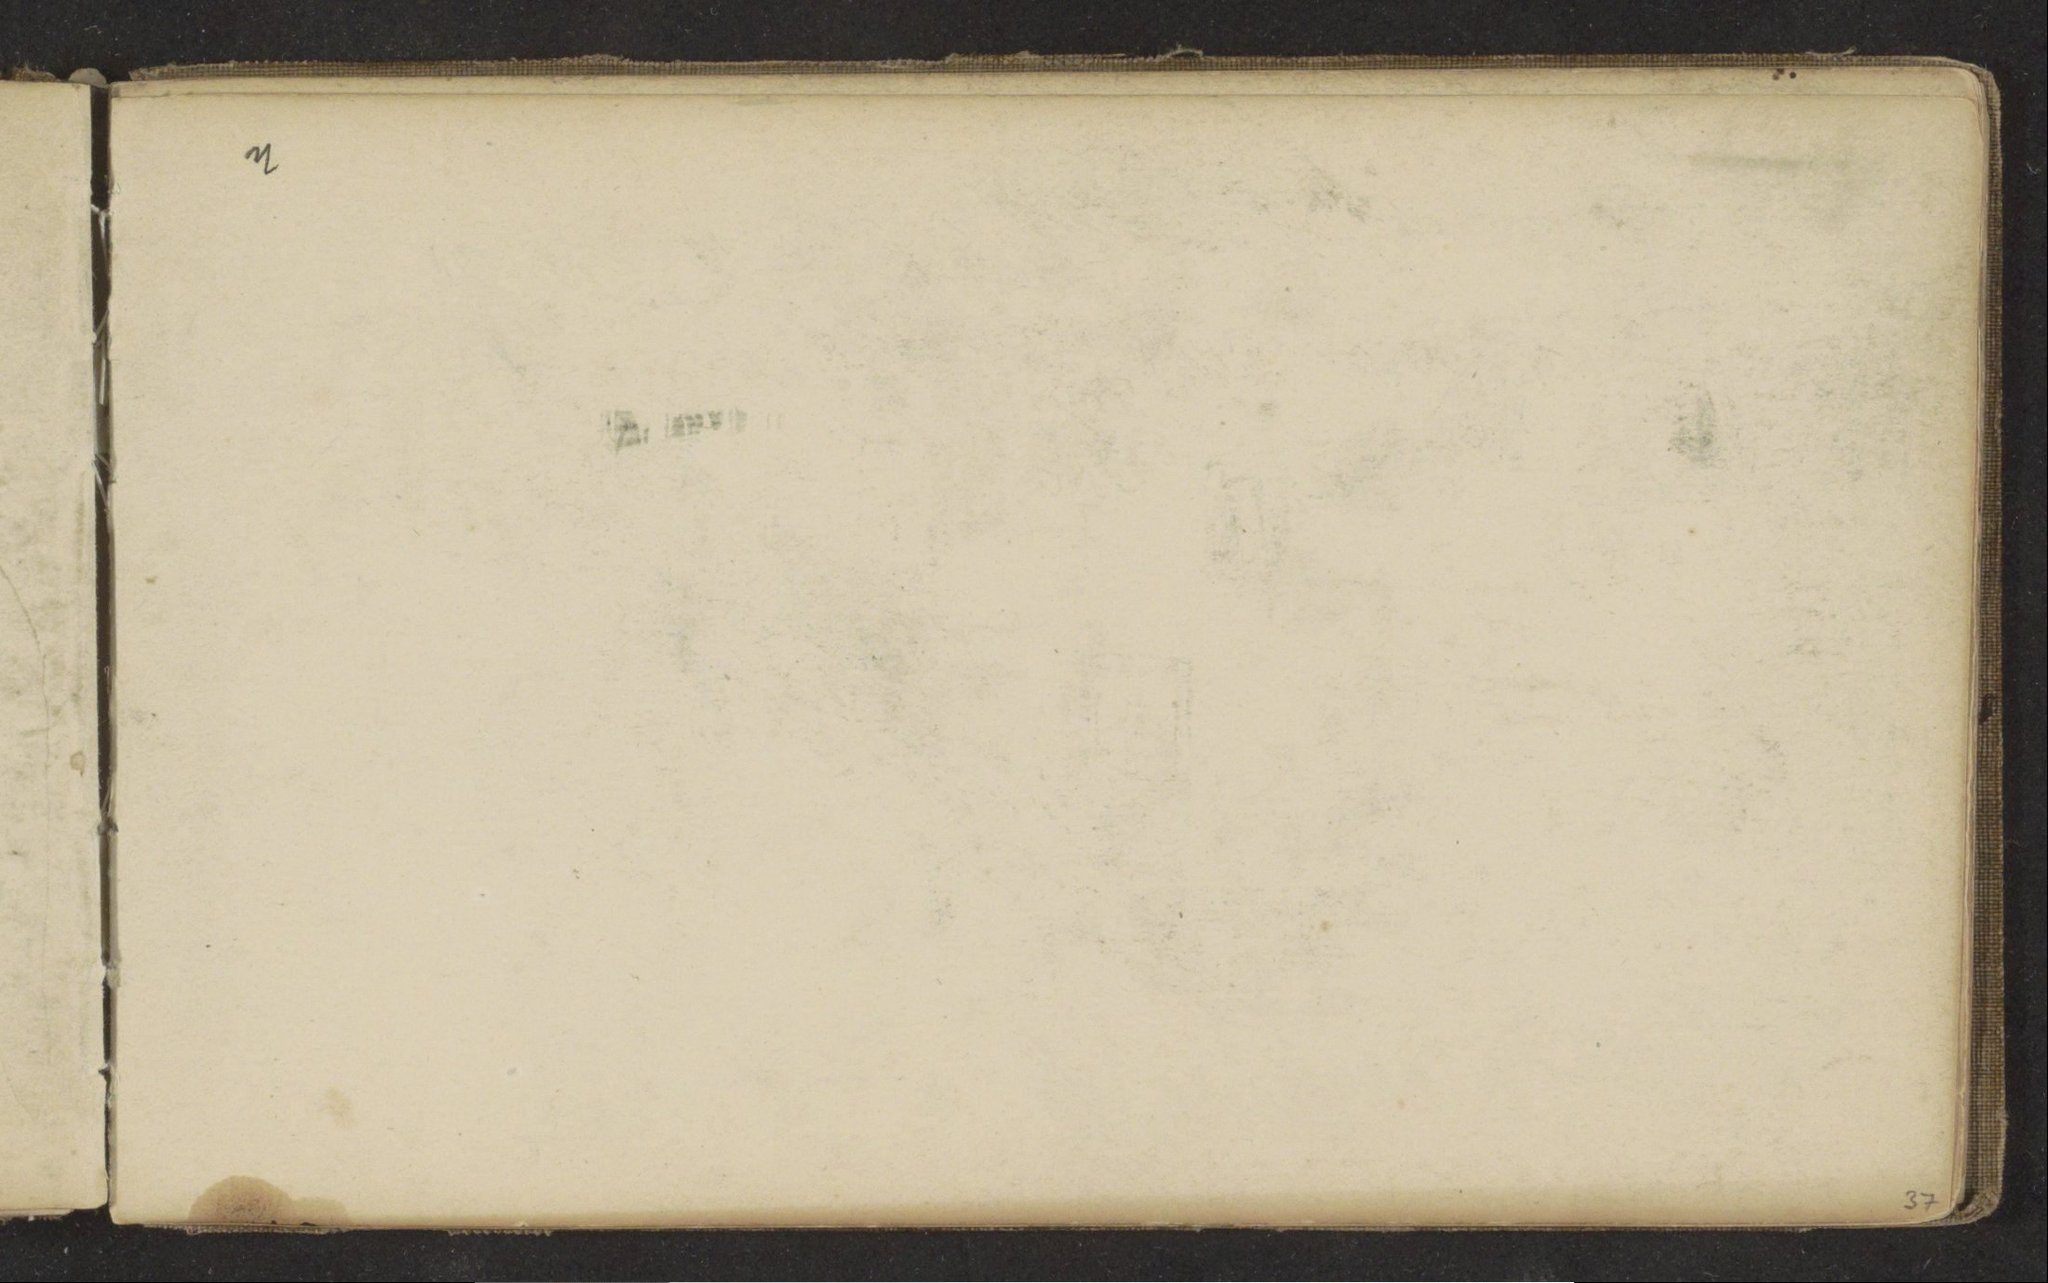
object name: sketchbook leaf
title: Studies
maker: johan hendrik weissenbruch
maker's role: draughtsman, painter, print maker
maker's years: 1824-1903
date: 1834-1903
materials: paper, pencil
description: Blad 37 recto uit een schetsboek met 43 bladen.